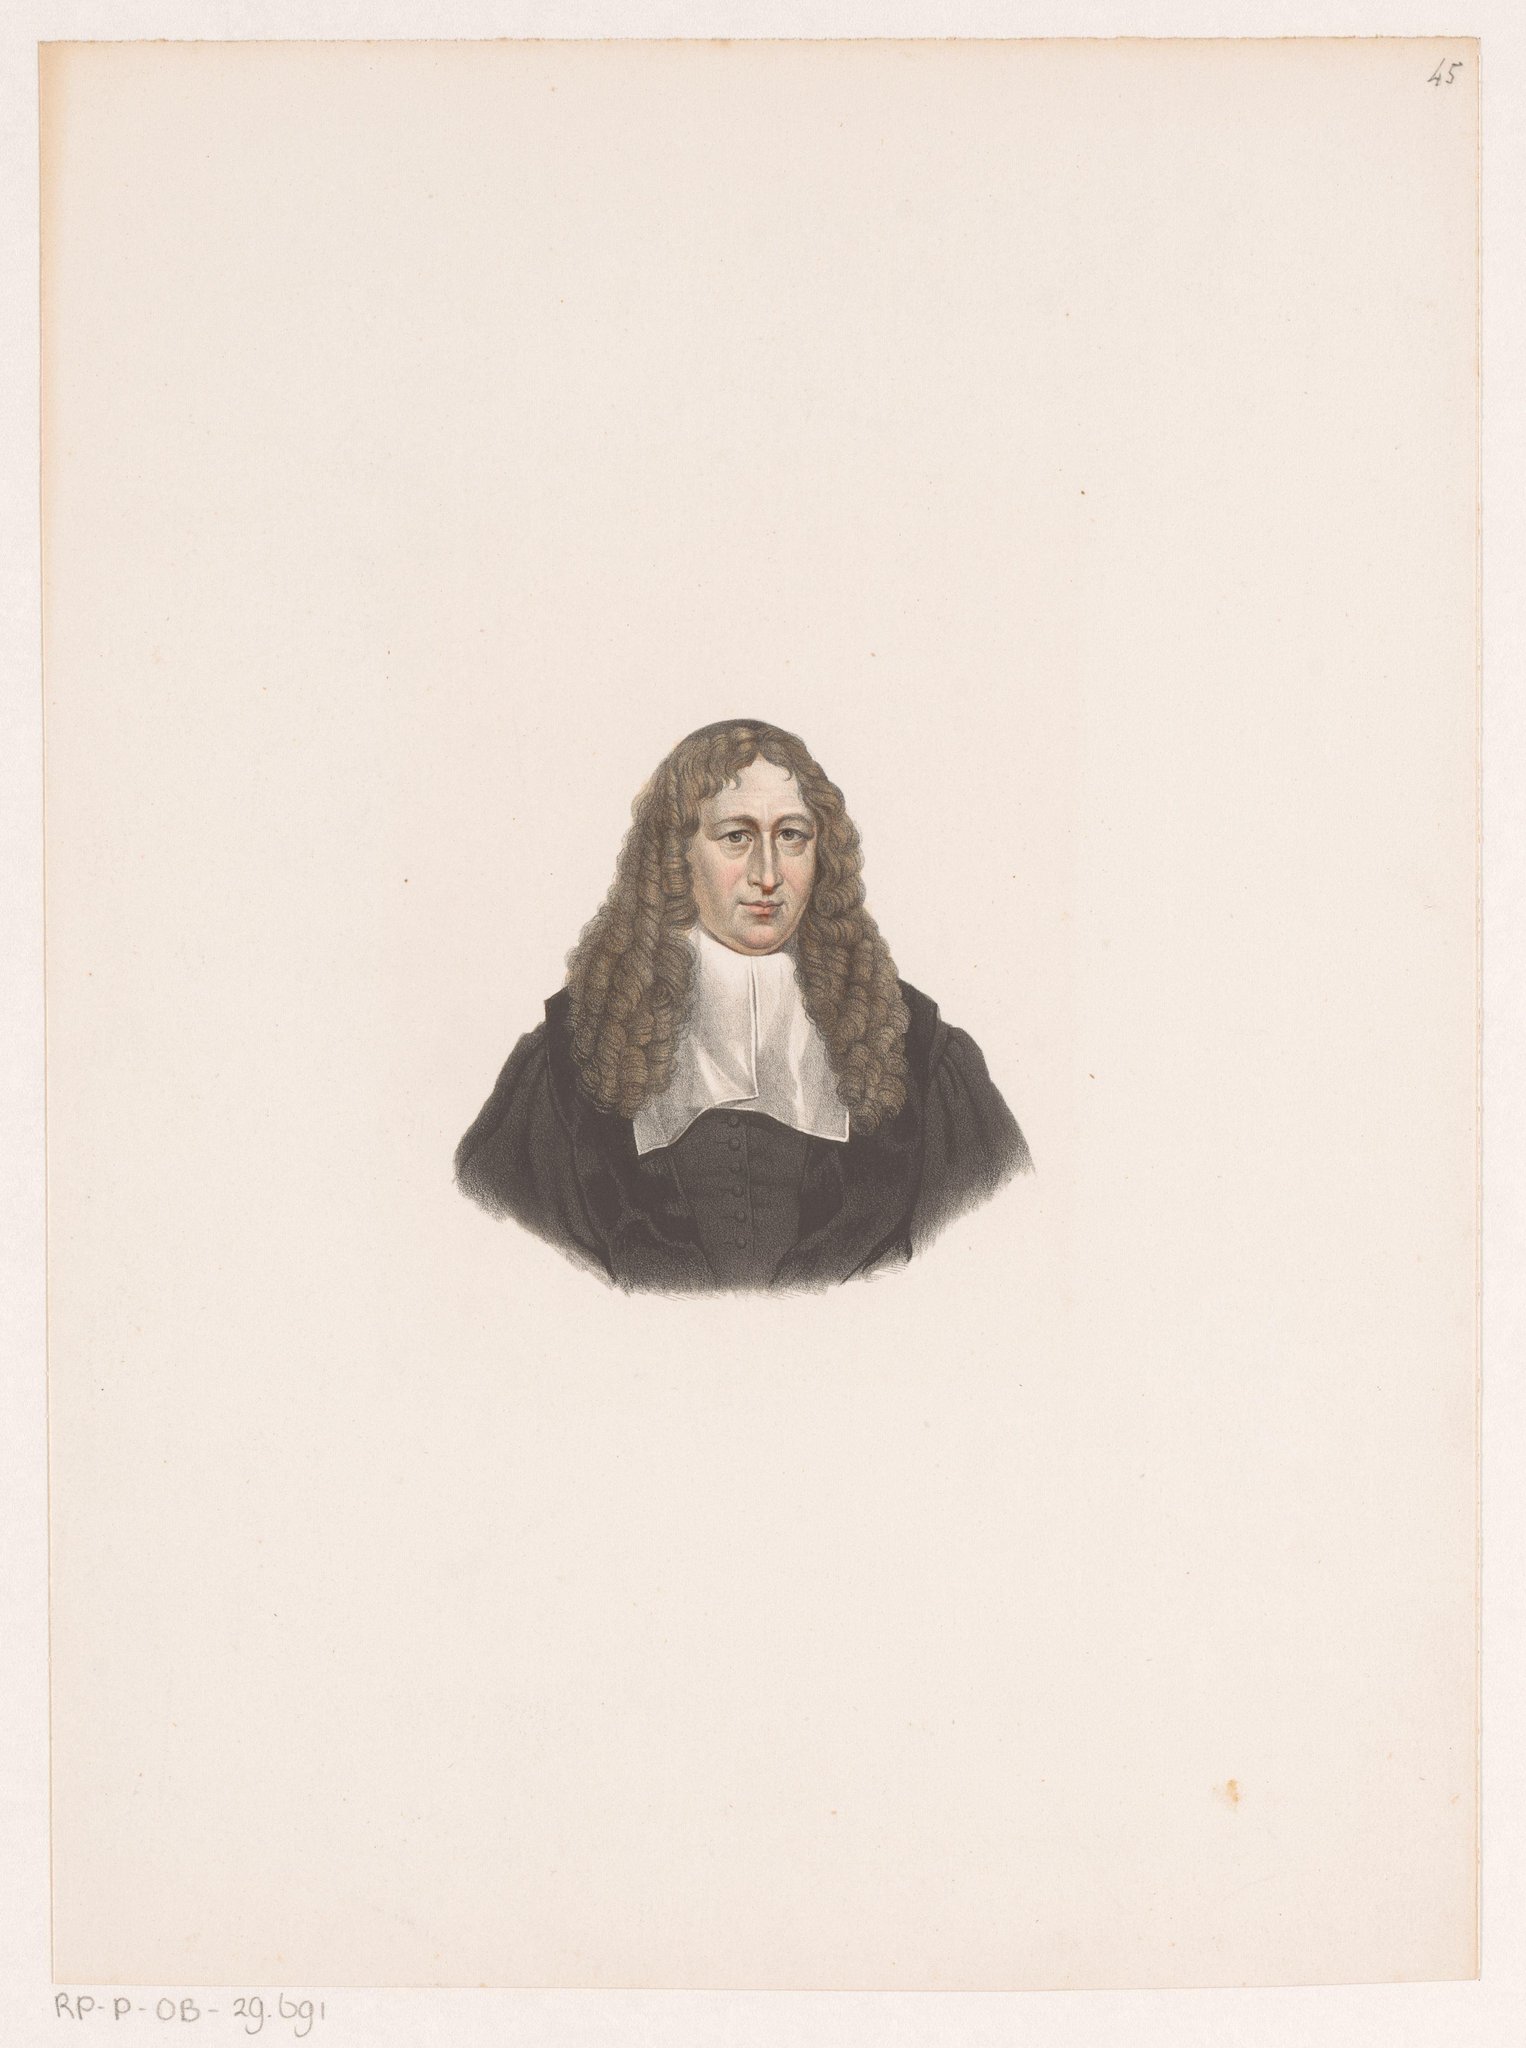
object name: print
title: Portret van Albertus Rusius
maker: leendert springer (i)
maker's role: draughtsman, painter, print maker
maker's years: 1789-1871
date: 1850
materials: paper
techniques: lithograph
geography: leiden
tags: leiden, historical persons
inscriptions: collector's mark: Lugt 2228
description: Proefdruk voor een prent uit: Springer, Leendert. Galerij van hoogleeraren aan de Hoogeschool te Leijden, naar de oorspronkelijke afbeeldsels op de Senaat-zaal aldaar berustende. Leiden: Springer, Leendert., s.a. [circa 1850].